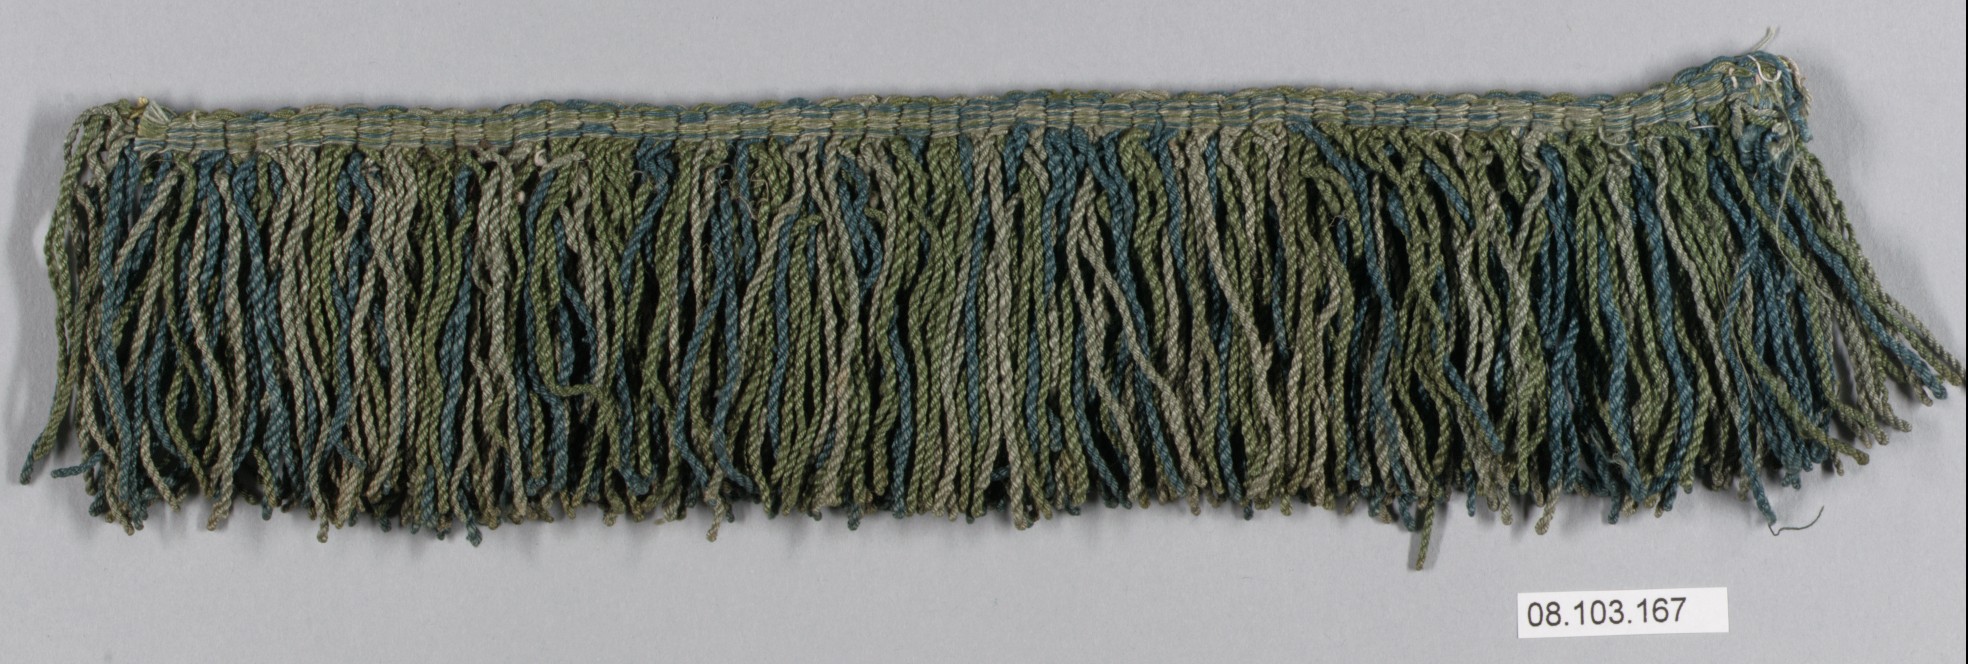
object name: fringe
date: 1601-1700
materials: cotton